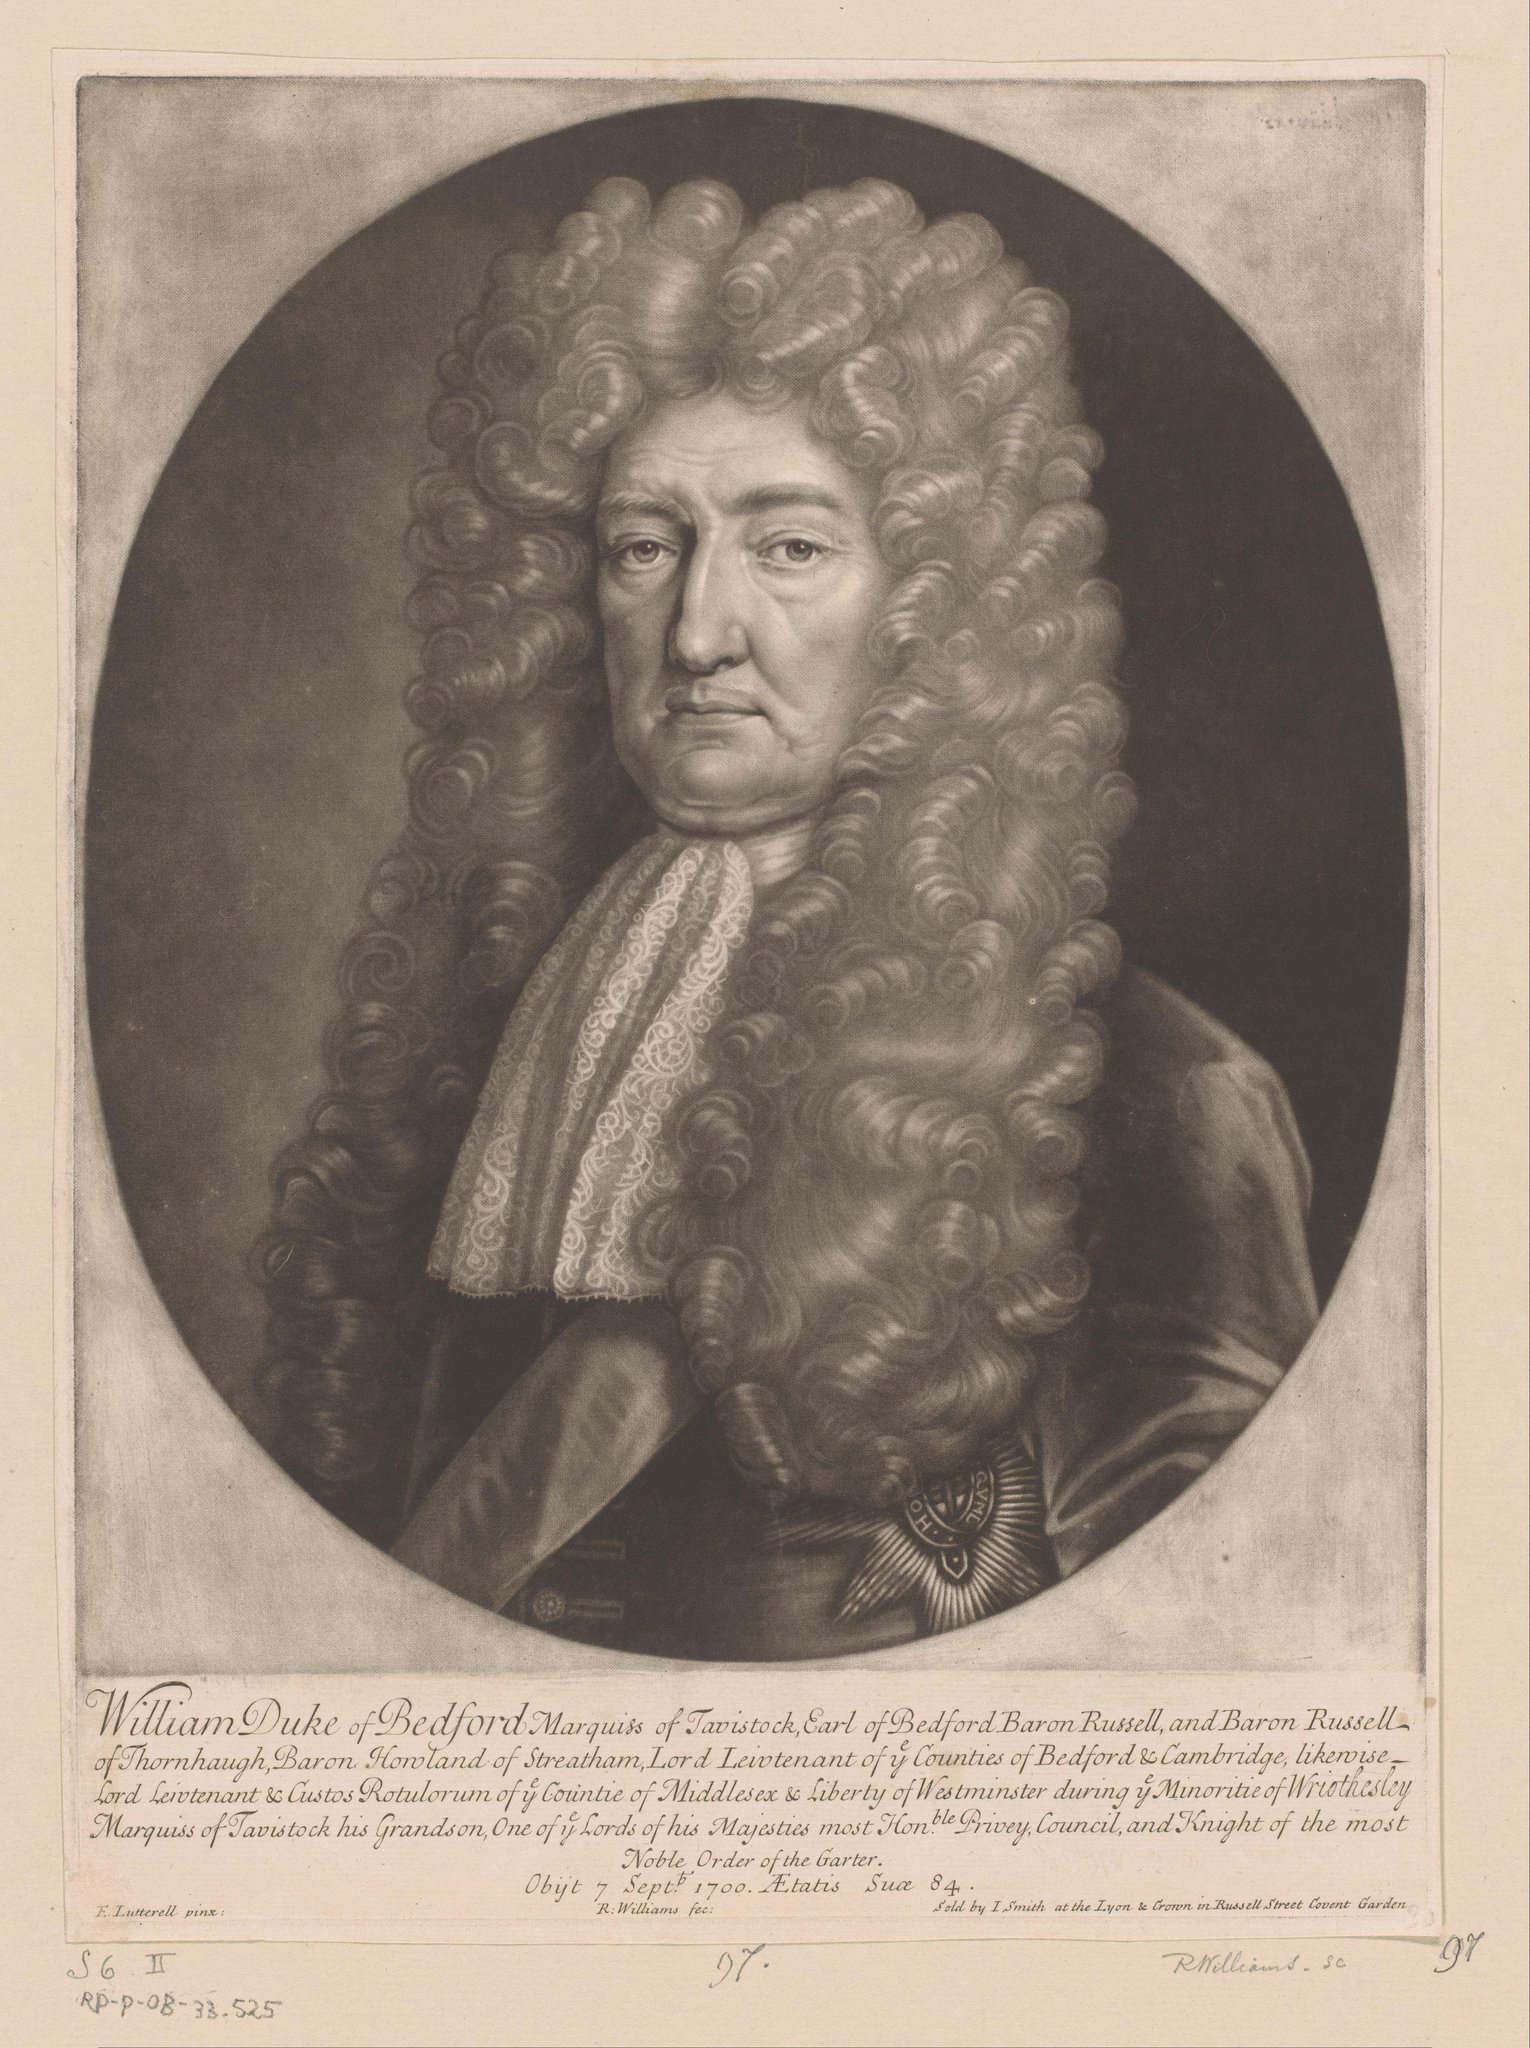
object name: print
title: Portret van William Russell op 84-jarige leeftijd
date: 1700-1742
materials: paper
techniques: mezzotint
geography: london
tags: historical persons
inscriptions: collector's mark: Lugt 240